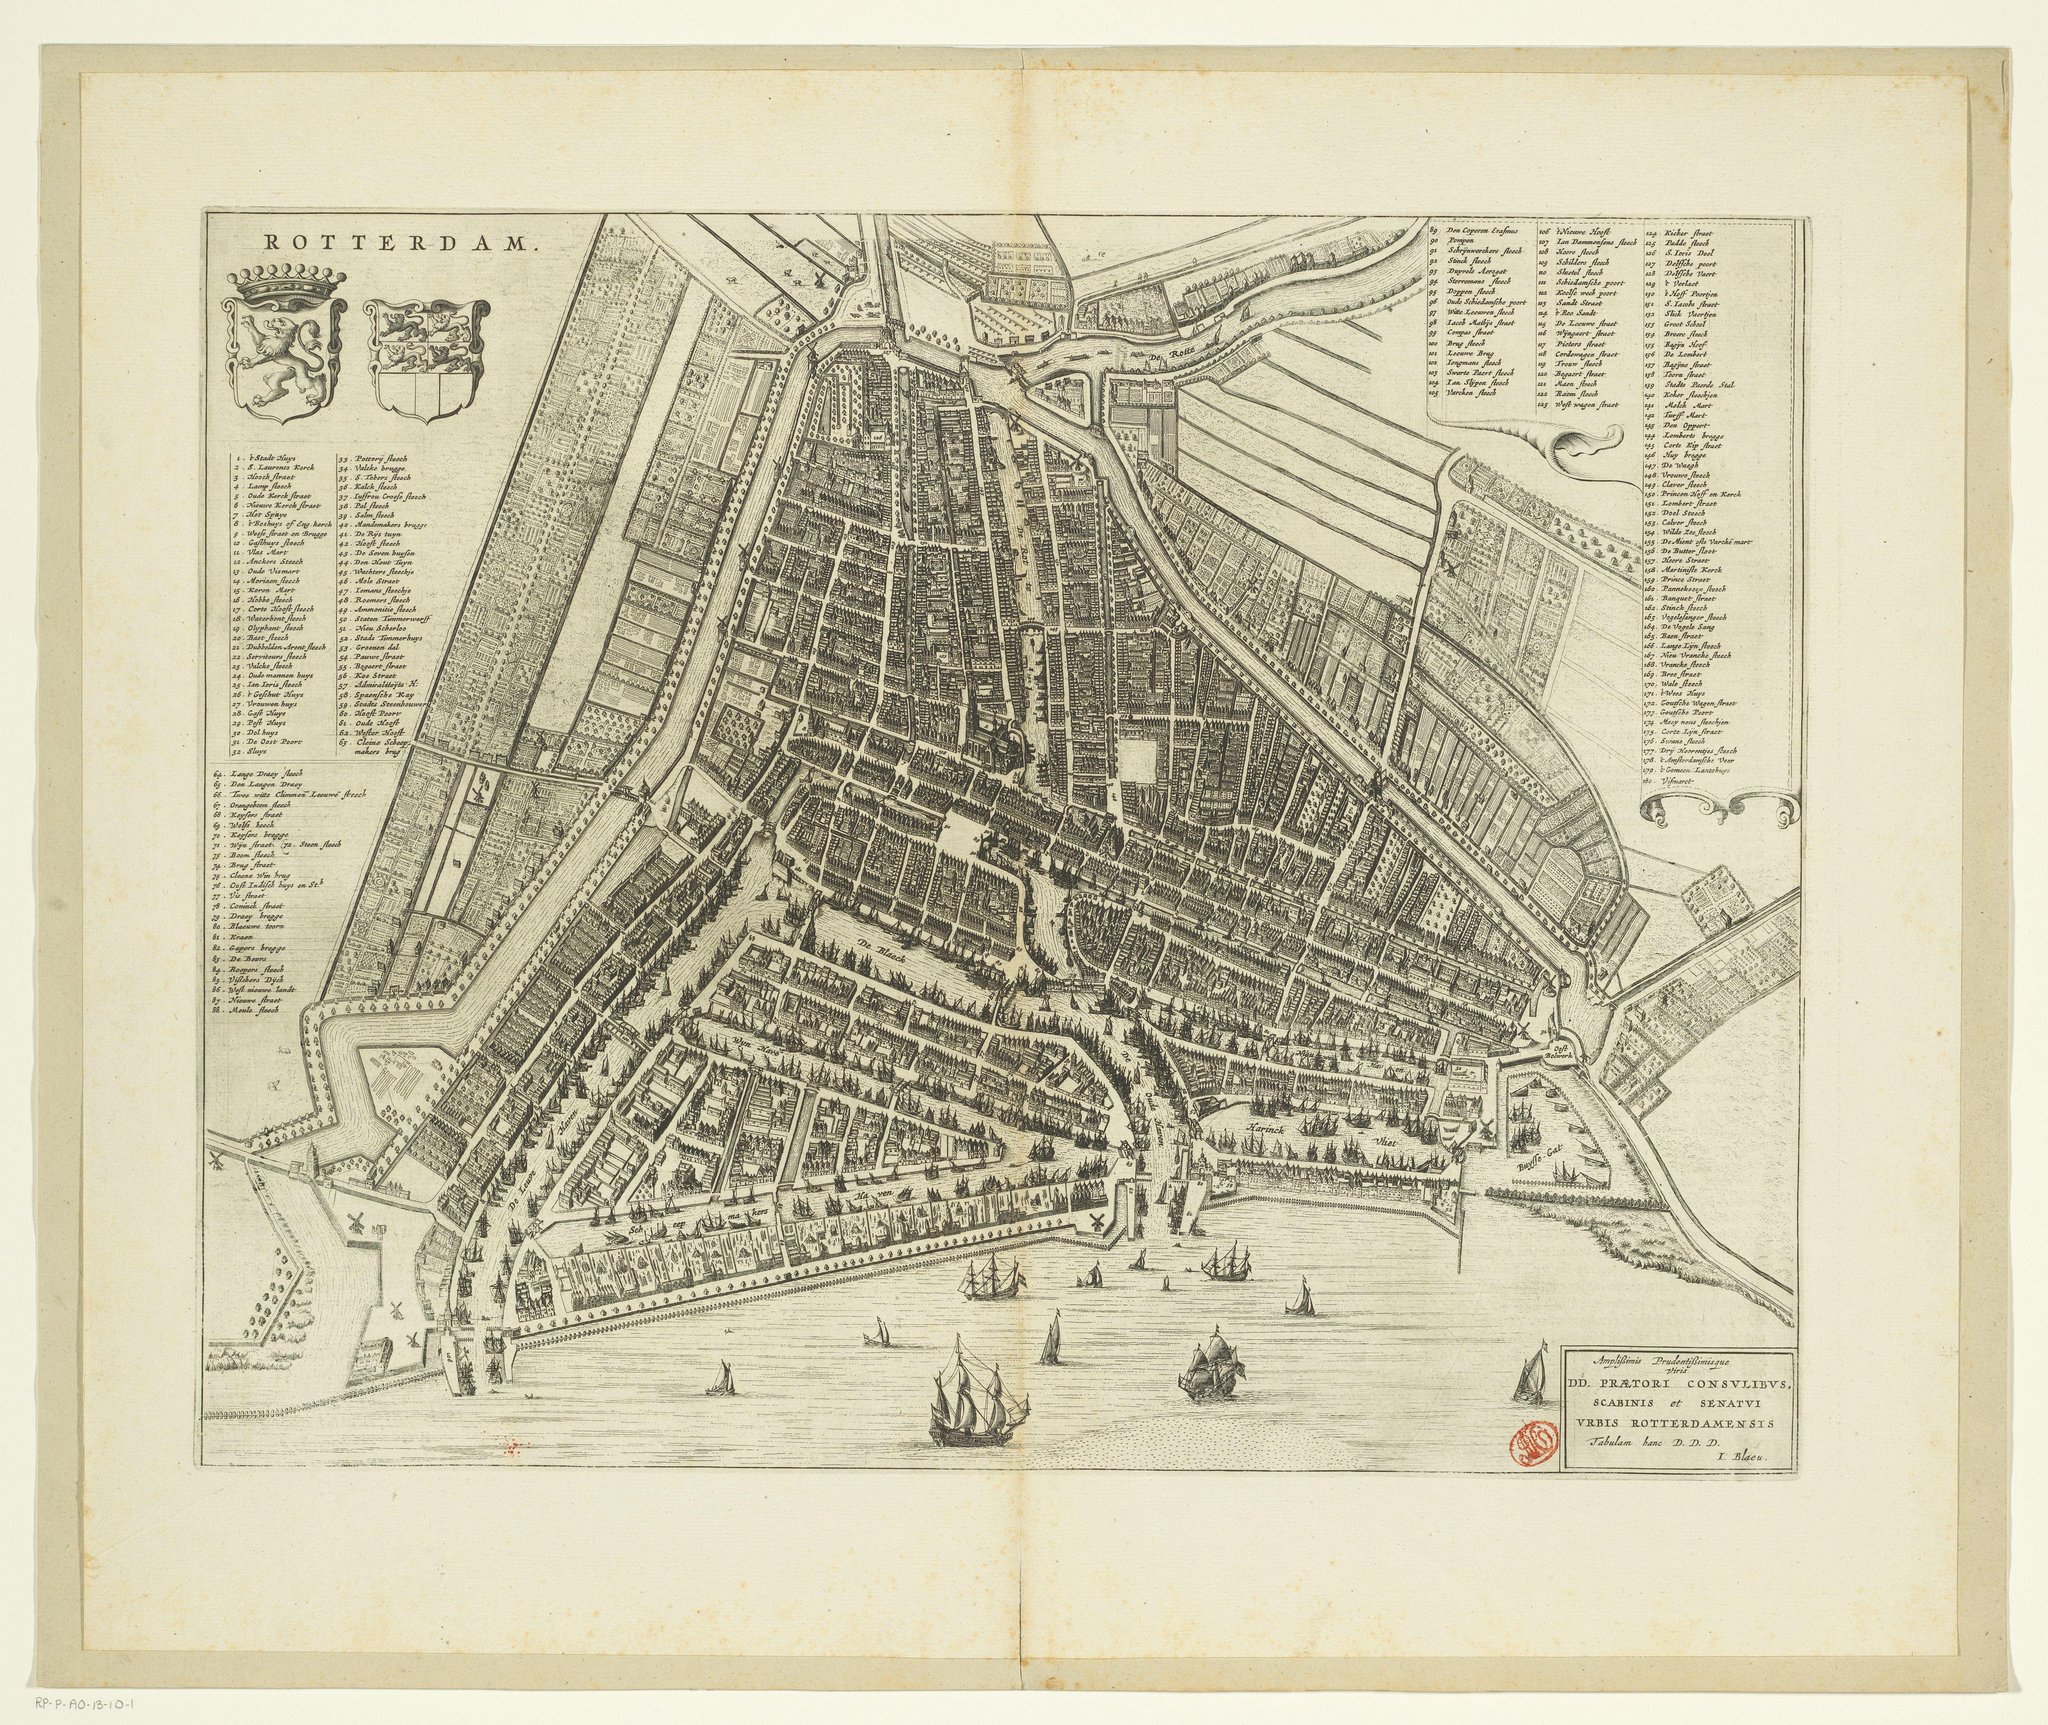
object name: area plan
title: Rotterdam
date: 1652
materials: paper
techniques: engraving, etching, letterpress printing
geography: rotterdam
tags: coat of arms (as symbol of the state, etc.) (+ city; municipal), maps of cities, coat of arms (as symbol of the state, etc.) (+ province; provincial), rotterdam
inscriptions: collector's mark: Lugt 195, collector's mark: Lugt 2228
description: Plattegrond in vogelvluchtperspectief. Linksboven de titel, de wapens van Holland en Rotterdam en de legenda 1-88 in het Nederlands. Rechtsboven de legenda 89-180 in het Nederlands. Rechtsonder een cartouche met de opdracht in het Latijn. Op verso Nederlandse tekst.